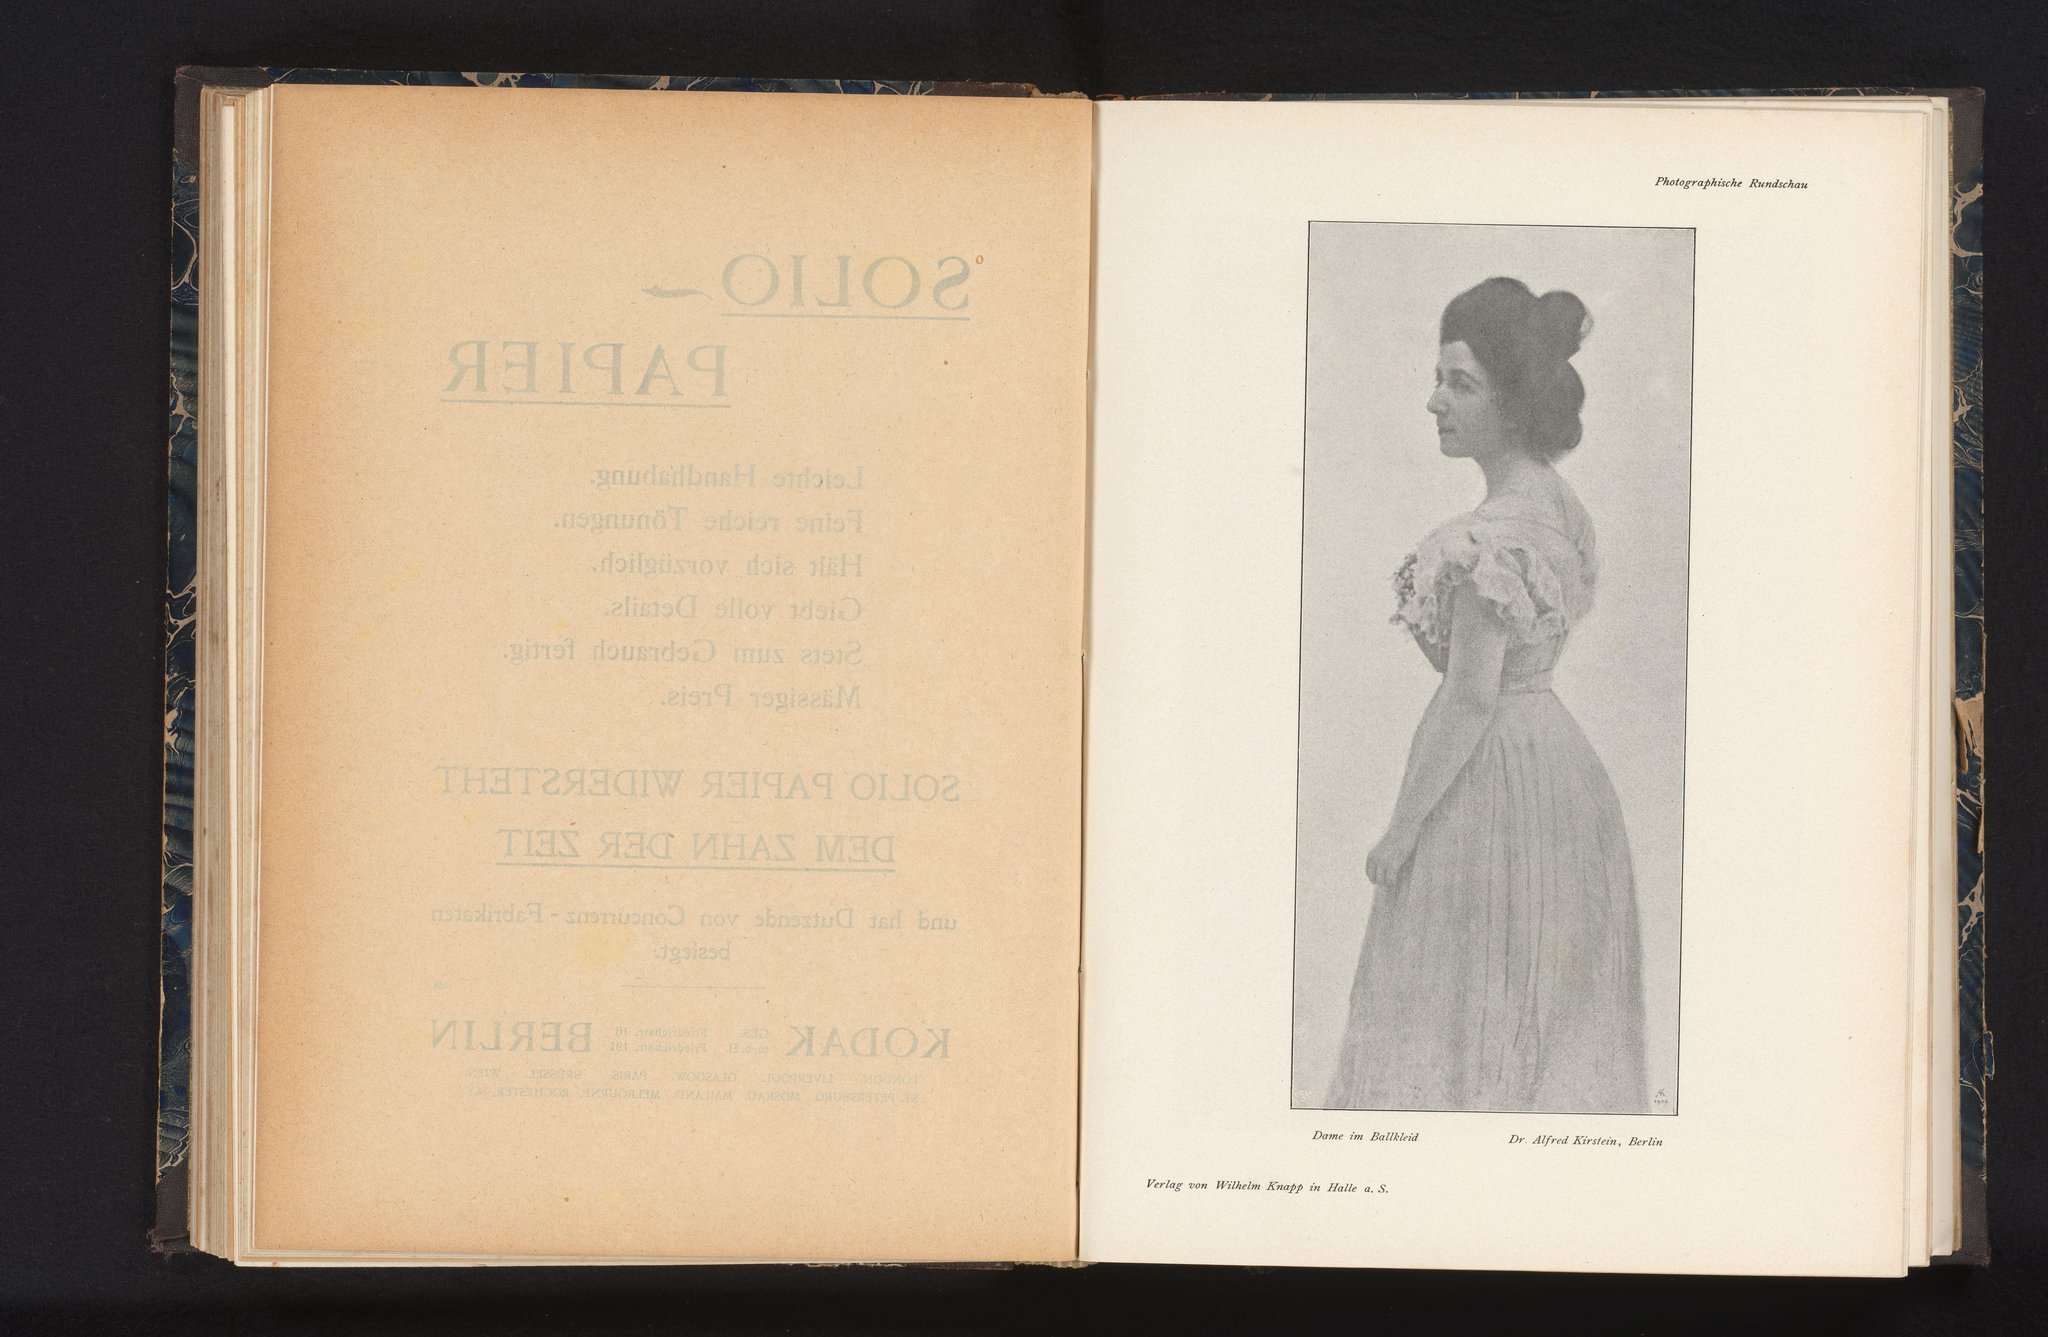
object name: photomechanical print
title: Portret van een onbekende vrouw in avondkleding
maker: alfred kirstein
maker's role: painter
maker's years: 1863-1922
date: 1897-1902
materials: paper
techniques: autotype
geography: berlin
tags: adult woman, anonymous historical person portrayed